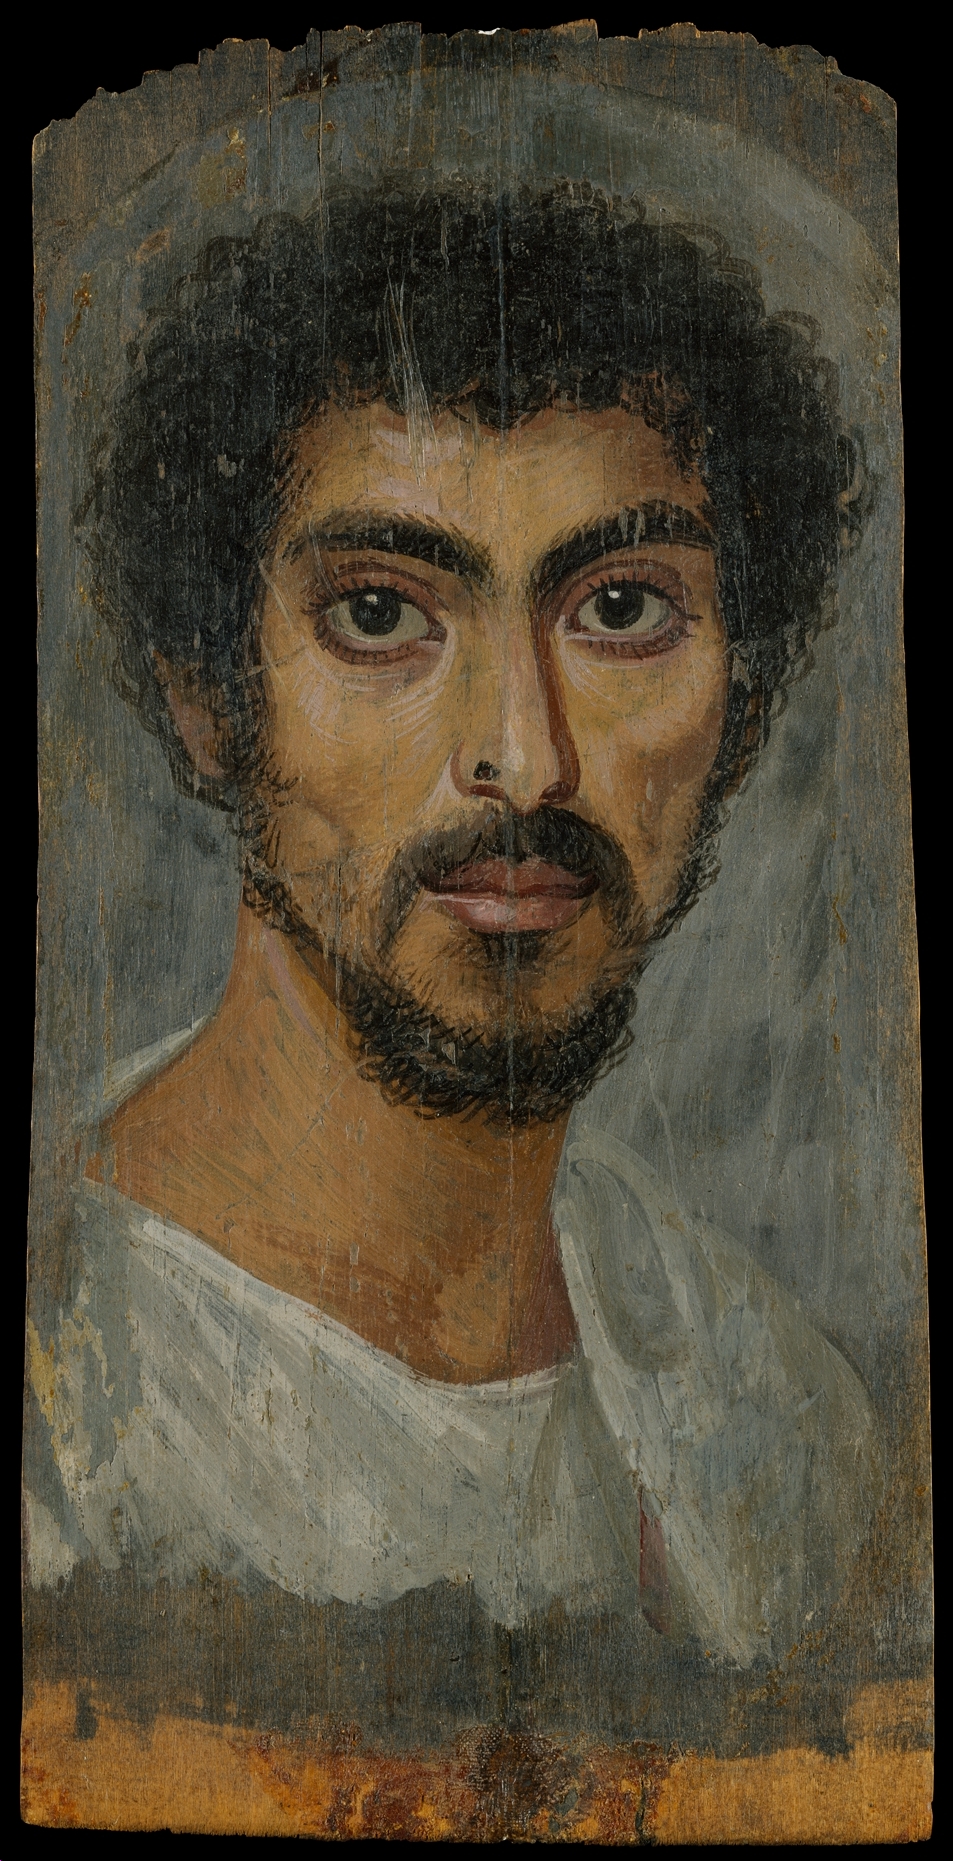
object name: panel painting, man with a mole on his nose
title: Portrait of a man with a mole on his nose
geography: egypt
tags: men,portraits